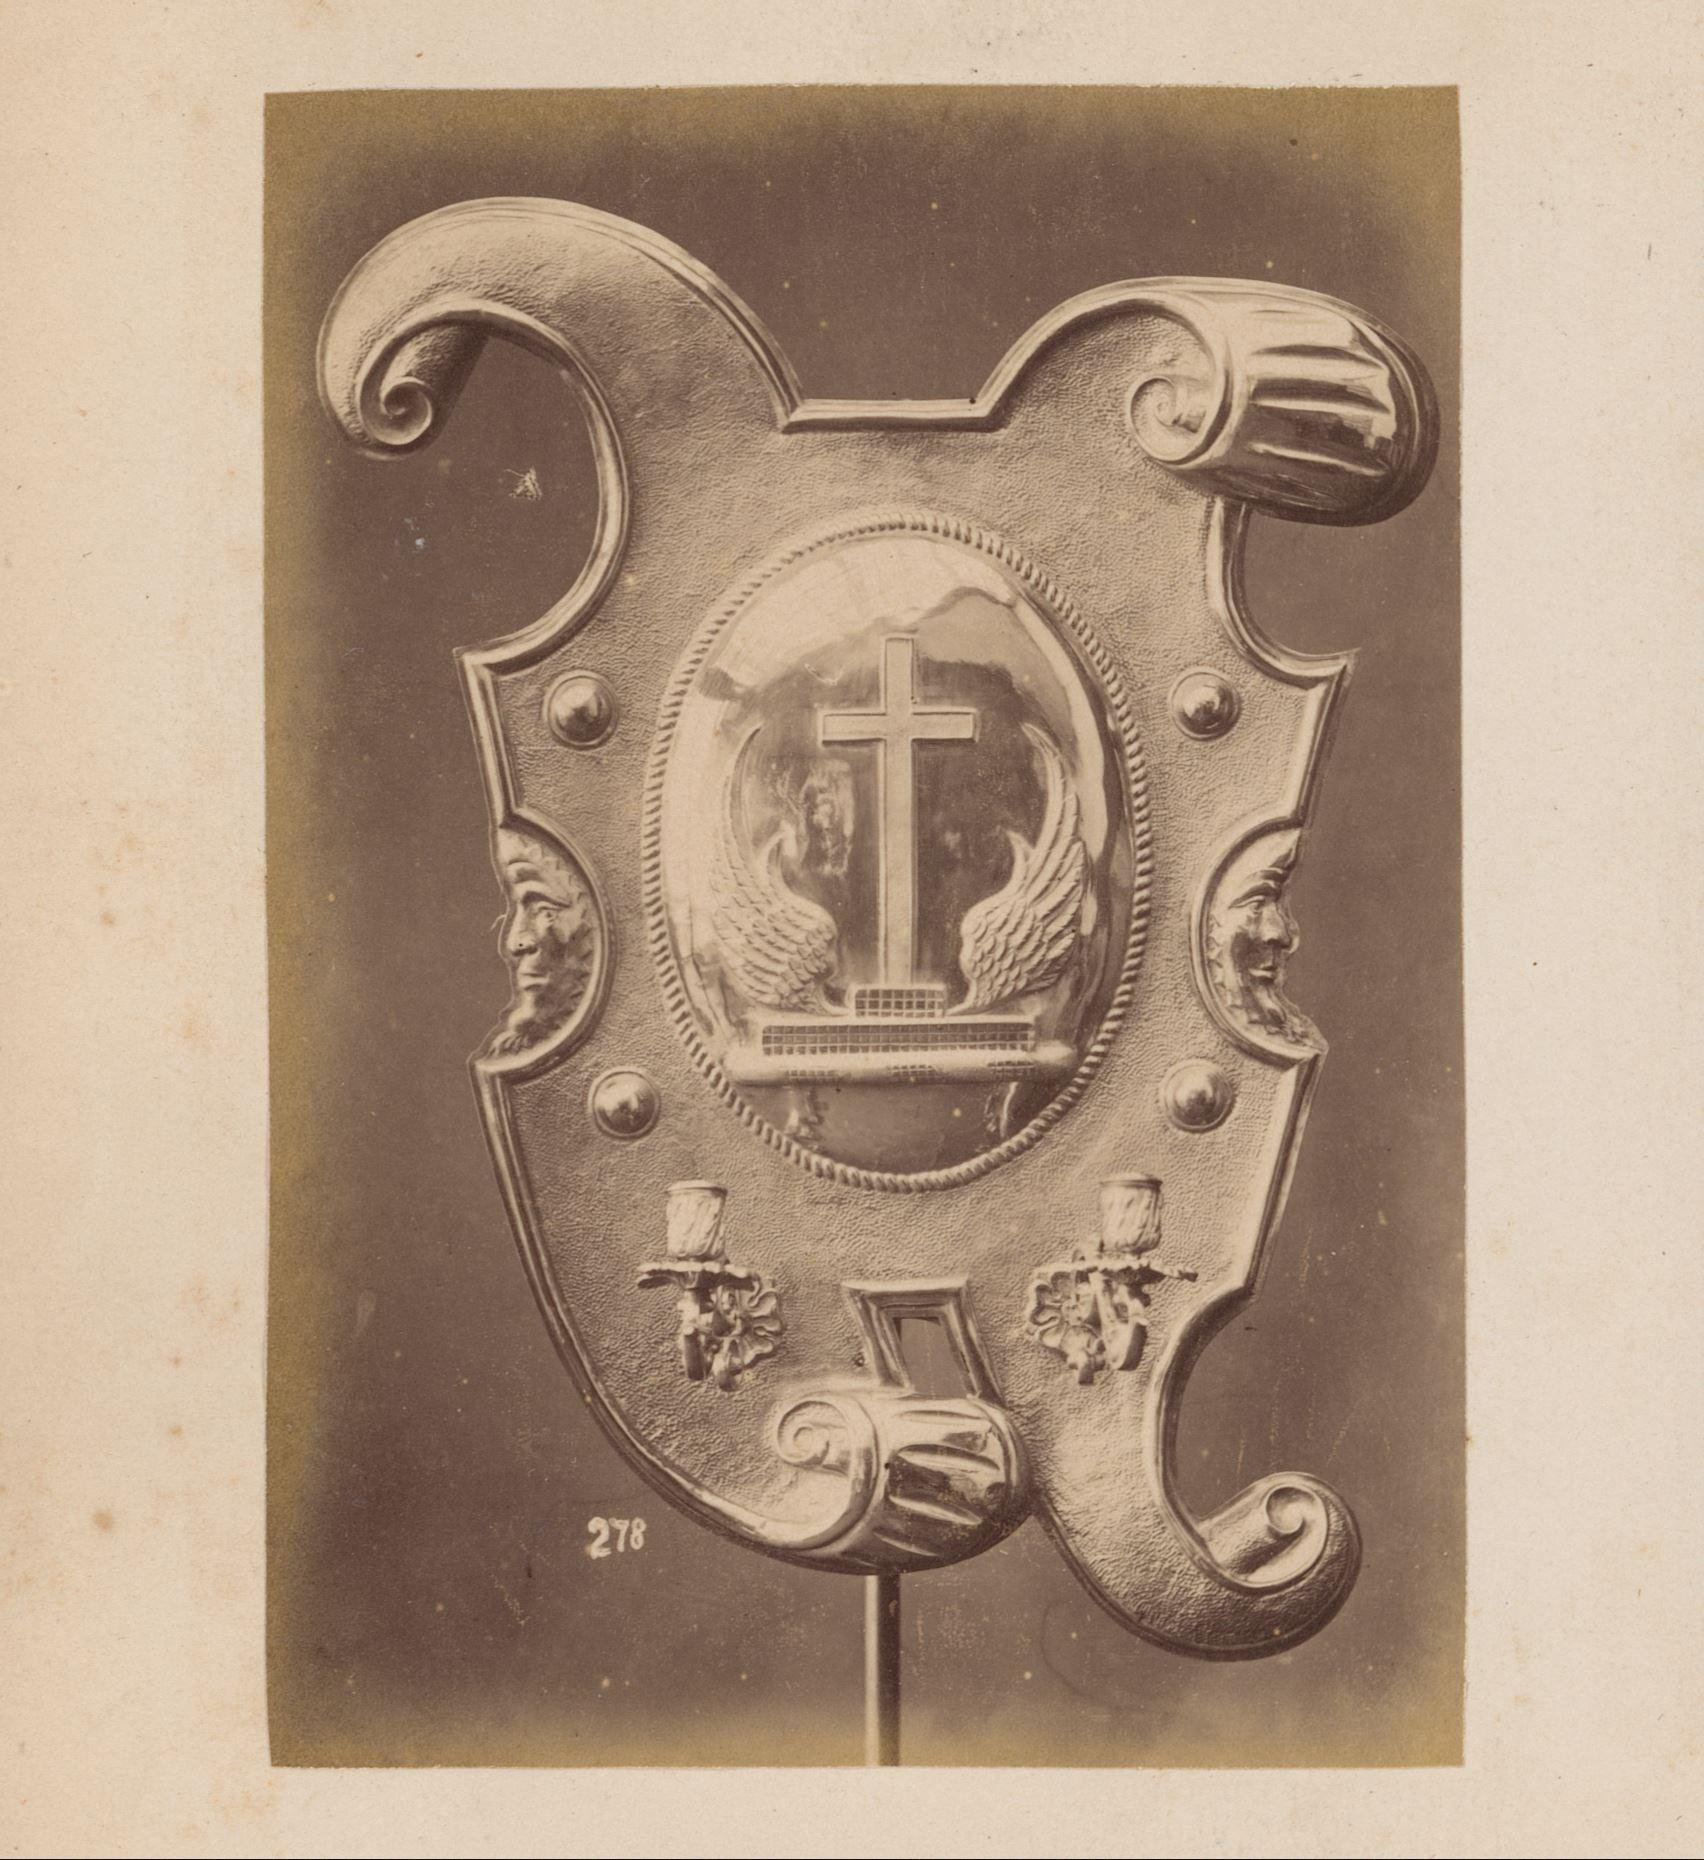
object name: page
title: Metalen wapenschild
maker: Anonymous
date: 1860-1885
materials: photographic support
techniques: albumen print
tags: coat of arms (as symbol of the state, etc.)